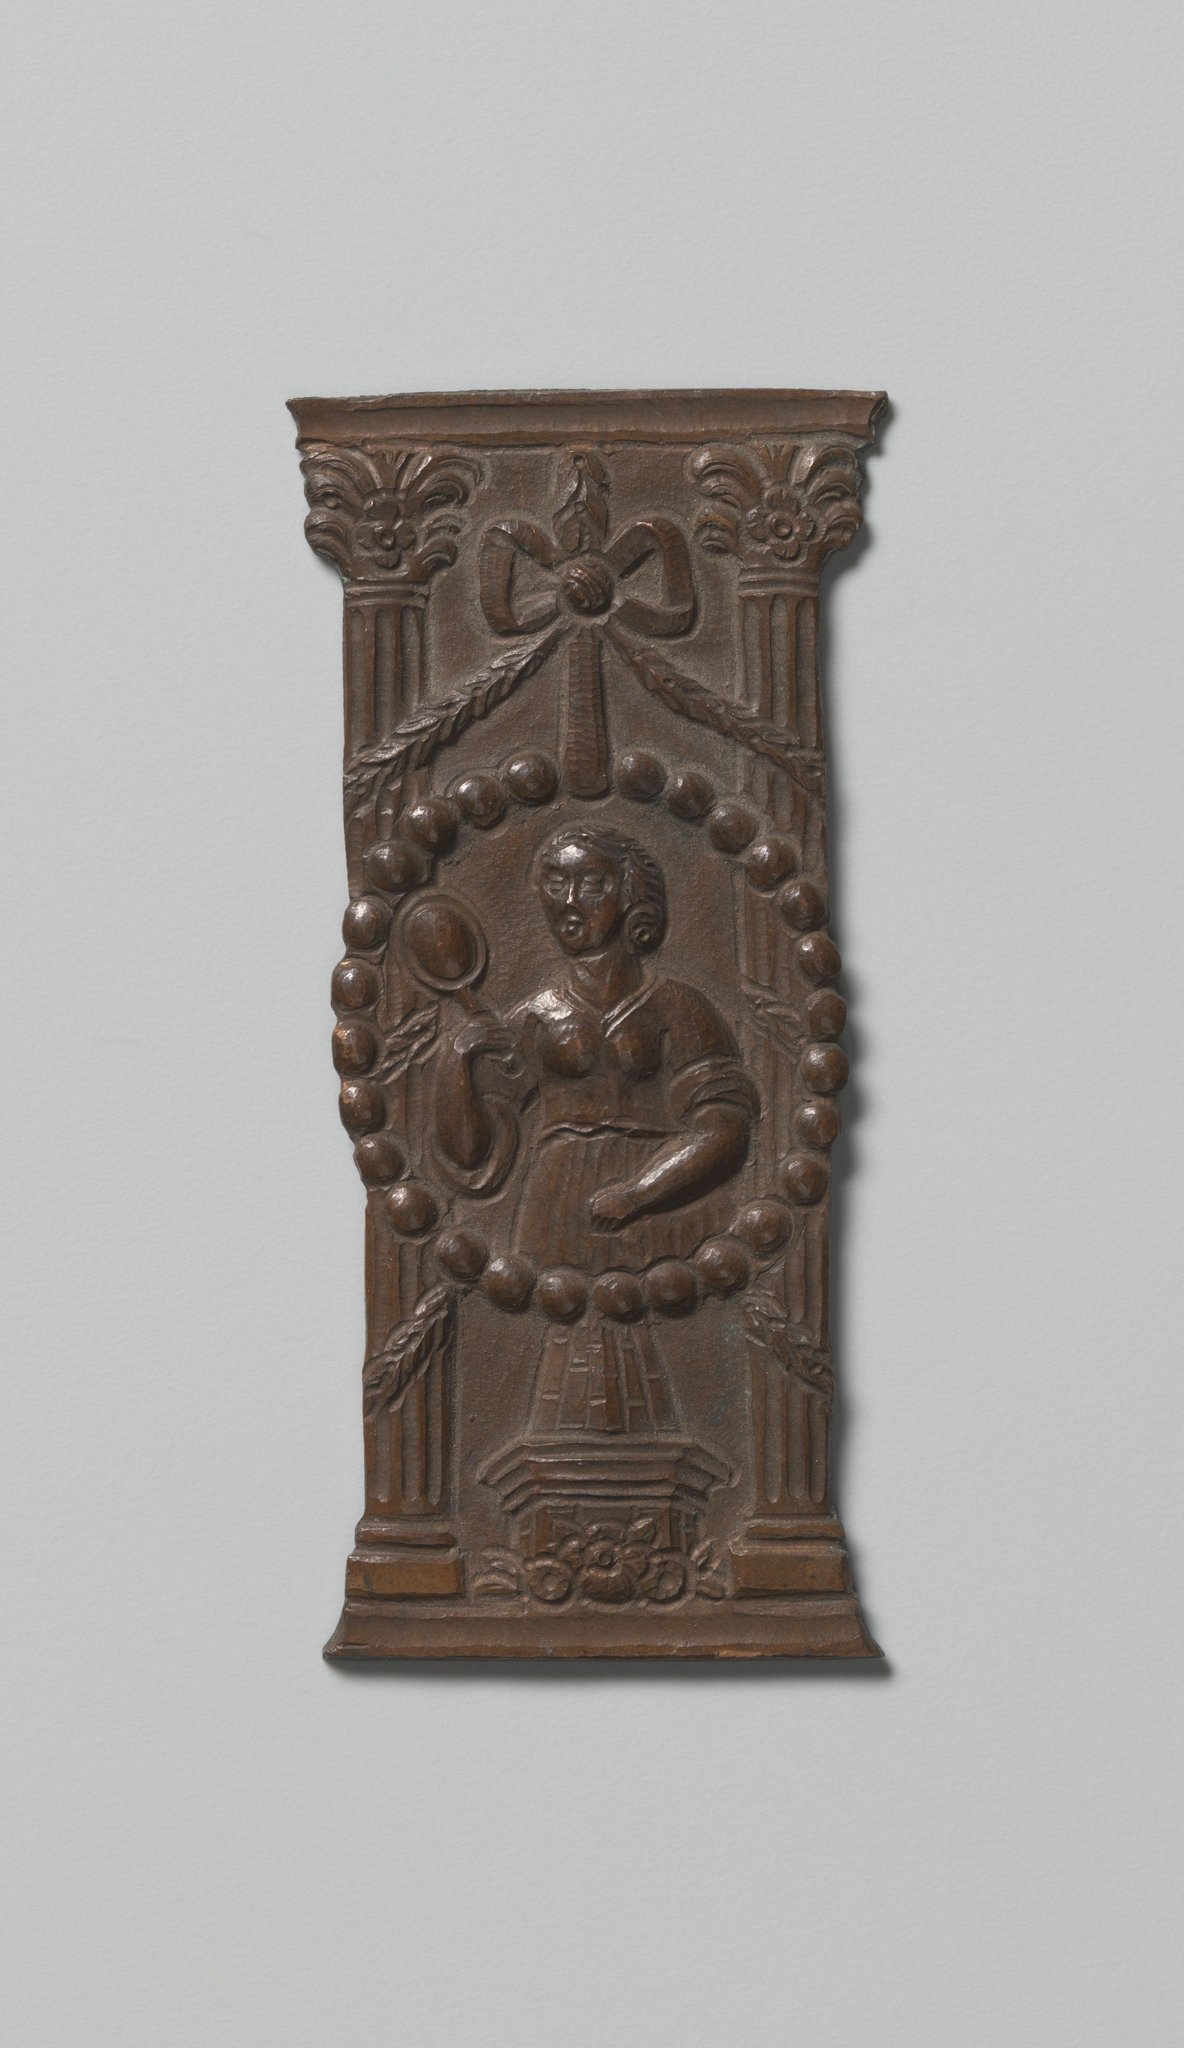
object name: model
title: Model voor een beugel van een boekslot met een vrouwe met spiegel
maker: Anonymous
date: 1775-1800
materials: copper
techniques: repoussé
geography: amsterdam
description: Het uit plaat gedreven model voor een gietvorm is versierd met een medaillon, waarin een vrouw met een spiegel. Het medaillon hangt aan een strik, waarvan twee slingers uitgaan, die om een pilaster zijn aangebracht.